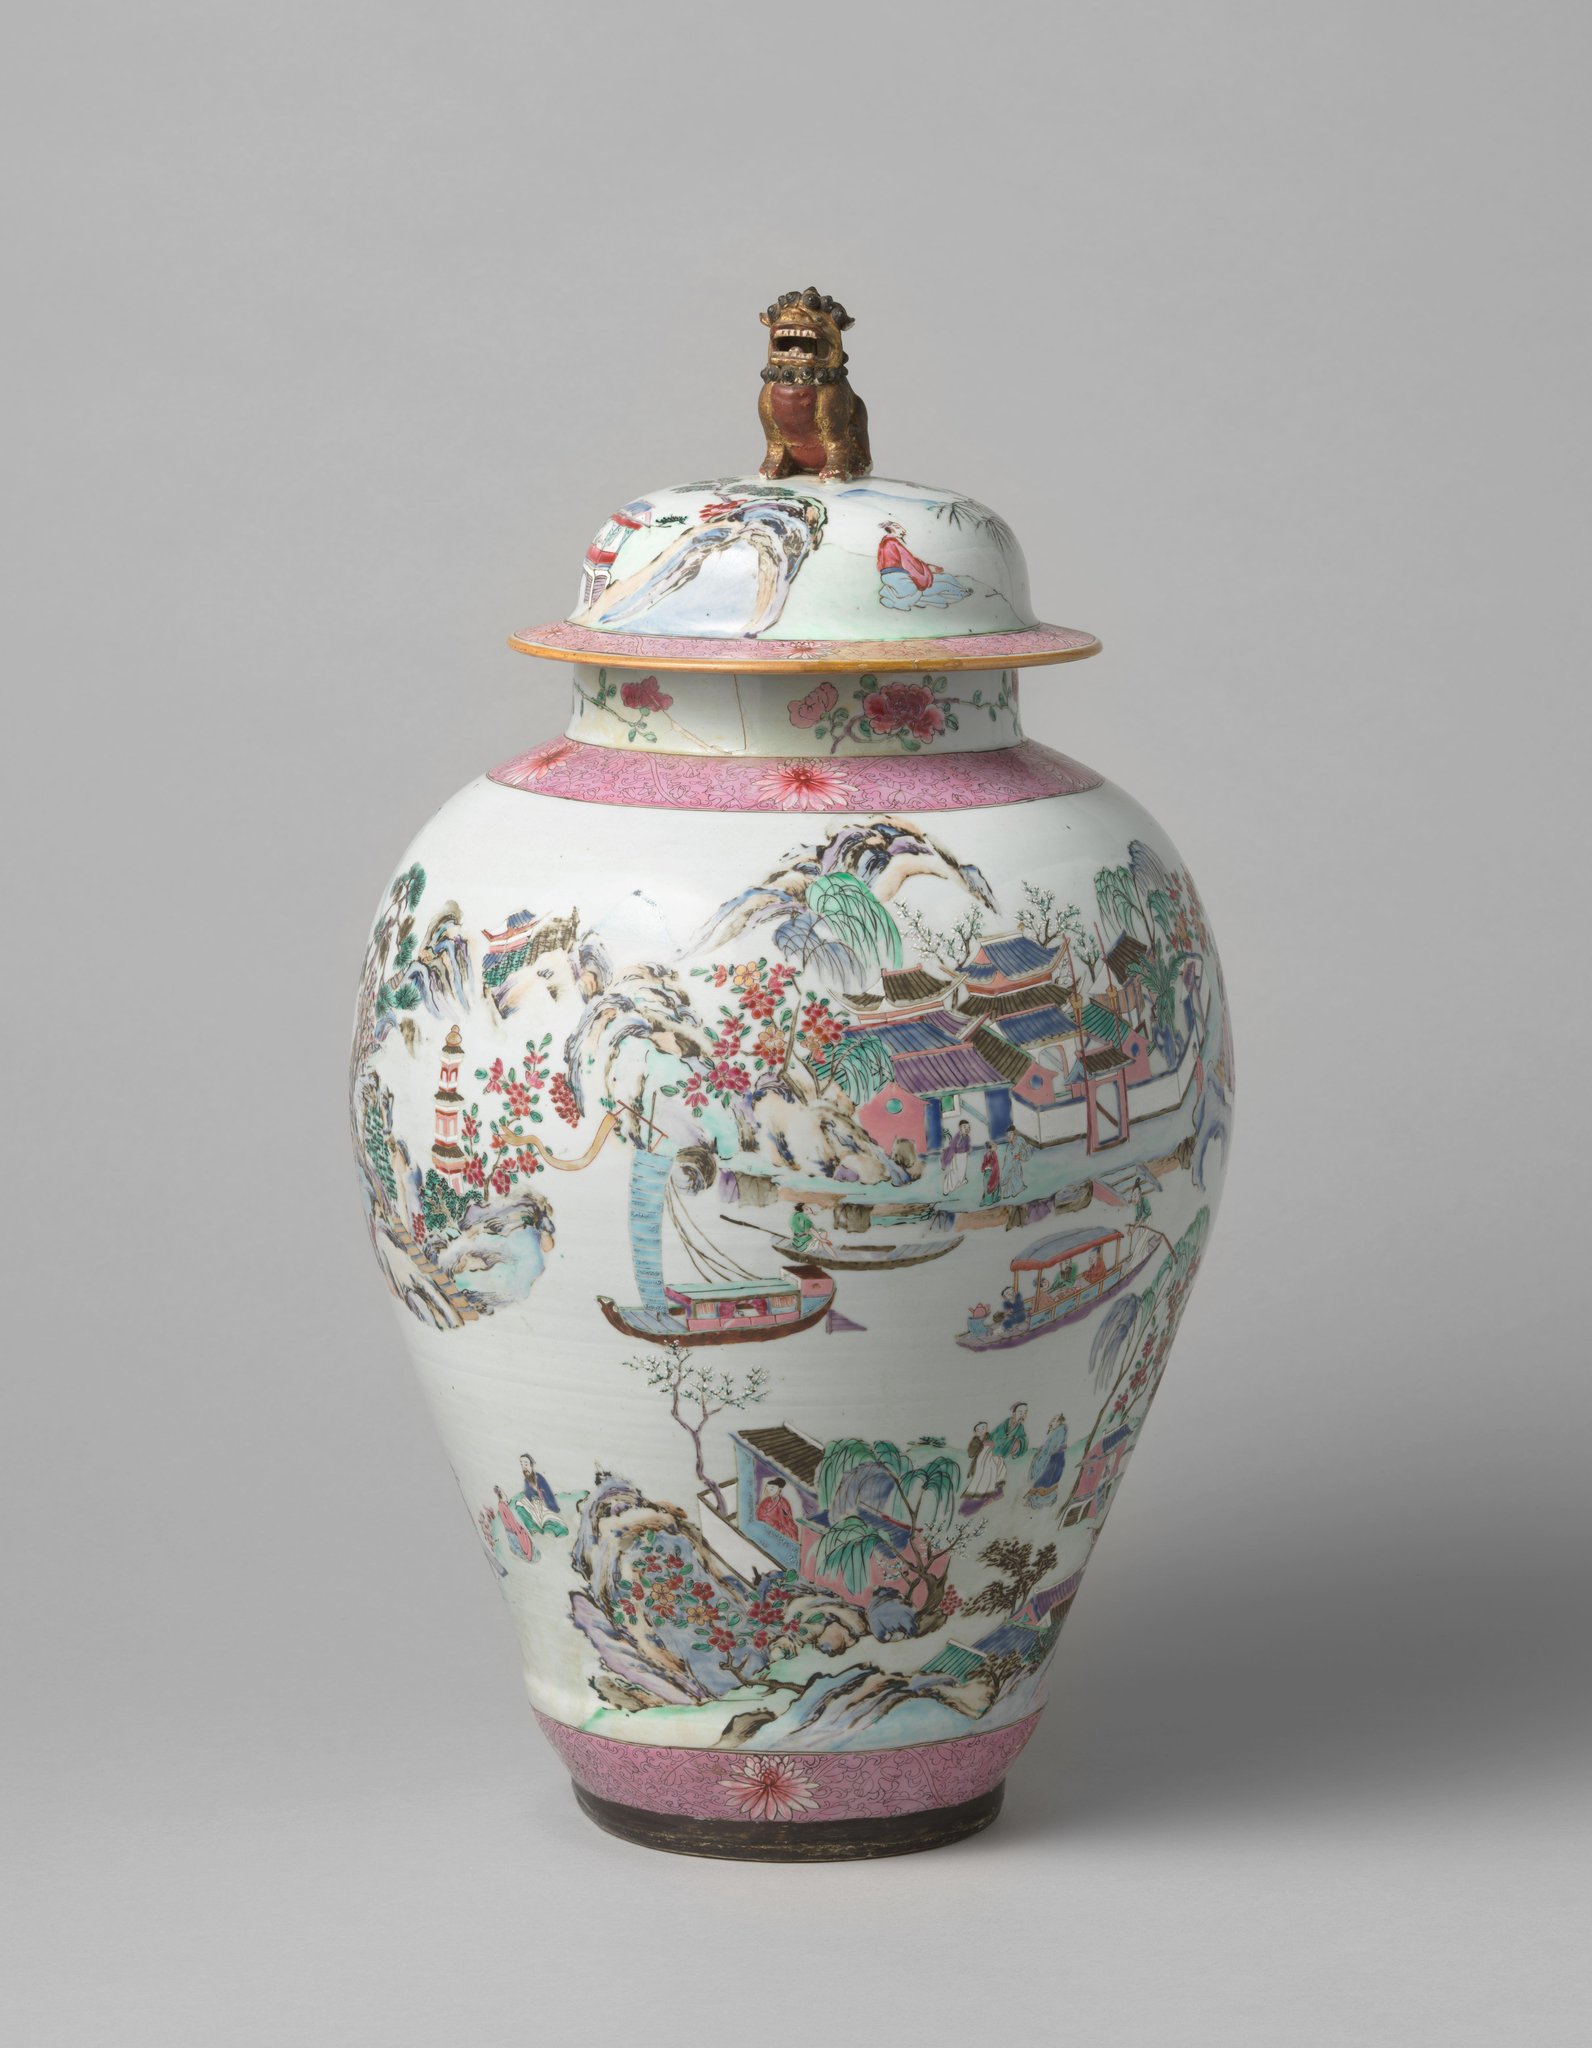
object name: pot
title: Baluster covered jar with a continuous landscape with figures, boats and pavillions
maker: Anonymous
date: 1850-1899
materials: glaze, gold, paint, porcelain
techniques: firing, forming, gilding, turning, vitrification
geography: china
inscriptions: label: ‘S. Alberge et Fils/ Antiquaires 11 plaats[...]/ La Haye/ Ho[...]’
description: Balustervormige dekselpot van porselein, beschilderd op het glazuur in blauw, rood, roze, groen, zwart en goud. Op de buik een doorlopend rivierlandschap met personen in boten. In de rivier enkele eilanden met personen op terrassen of bij paviljoens. In het landschap verschillende pijn- en prunusbomen. In de achtergrond bergen. Rond de voet en op de schouder een band met bloemranken onderbroken door een chrysant. De nek met drie pioentakken. De hals van de pot is gebroken geweest. Oud label in de deksel met 'S. Alberge et Fils/ Antiquaires 11 plaats[...]/ La Haye/ Ho[...]'. Famille rose.